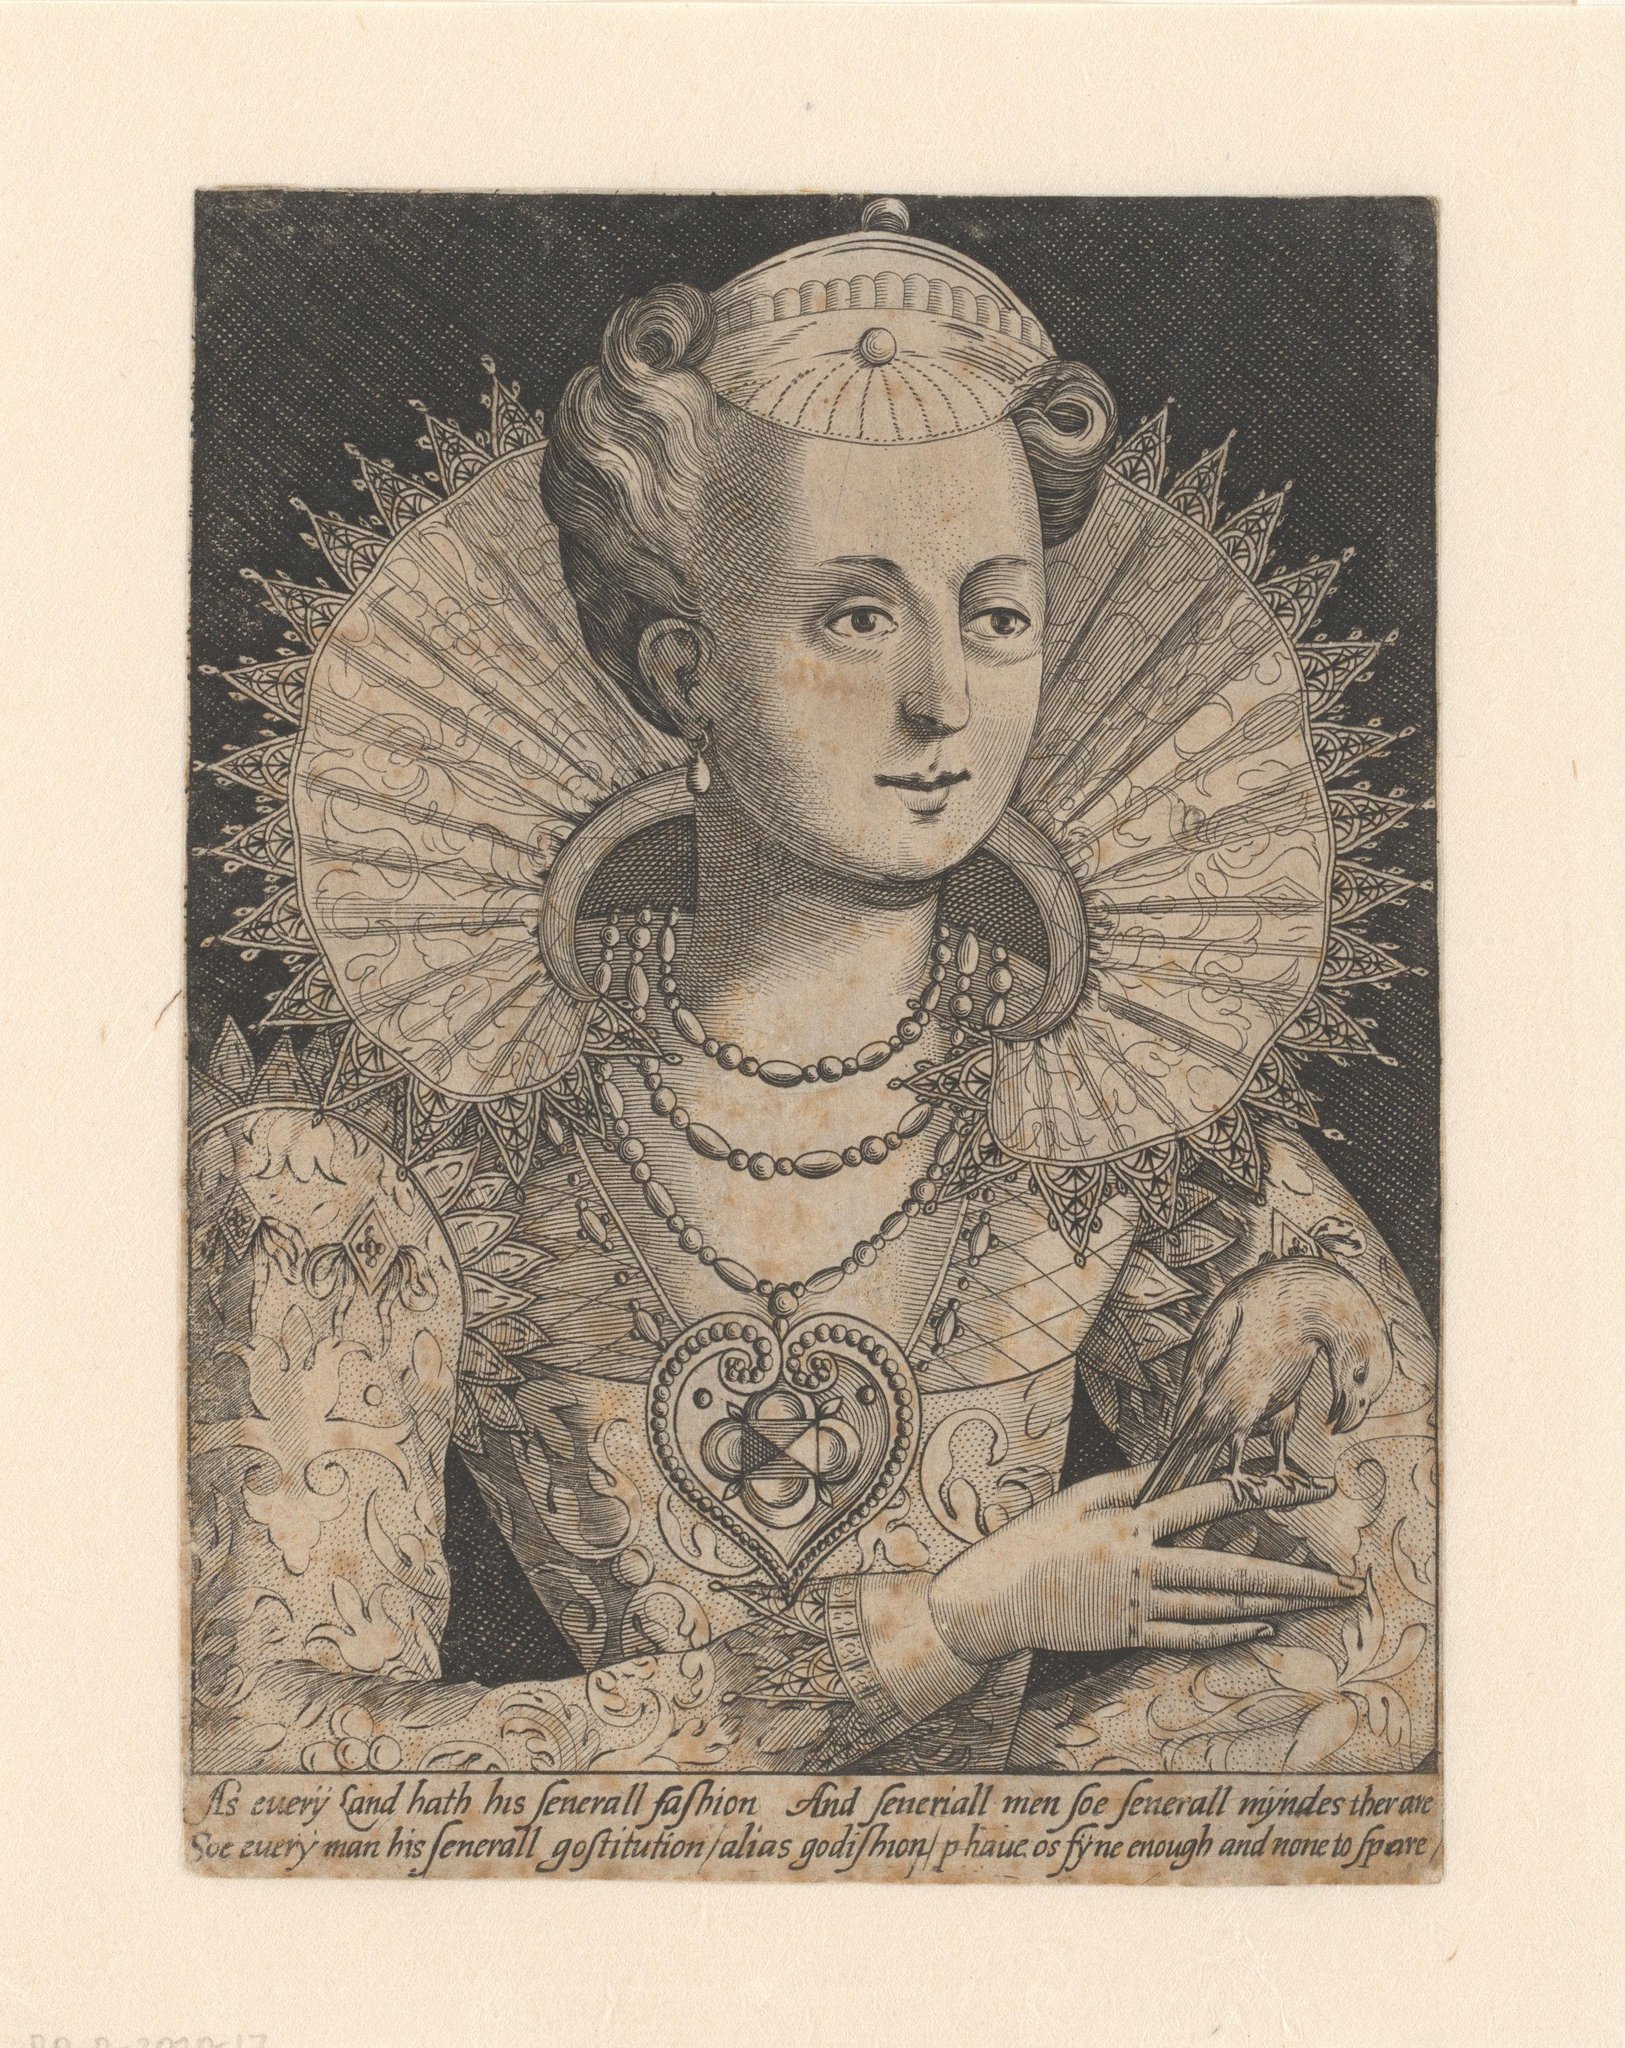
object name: print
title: Vijf zintuigen gepersonifieerd door vrouwen in modieuze kostuums en met kapsels uit verschillende landen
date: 1590-1620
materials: paper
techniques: engraving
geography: low countries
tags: styles of hairdress - aa - ~ women, fashion, feeling (one of the five senses) - aa - female human figure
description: Zintuig Gevoel. Modieuze jonge vrouw met een vogel op haar vinger. Prent uit een serie met vijf zintuigen, waarin de vijf zintuigen zijn gepersonifieerd door vrouwen in modieuze kostuums en met kapsels uit verschillende landen en voorzien van attributen. Met onderschrift in het Engels.